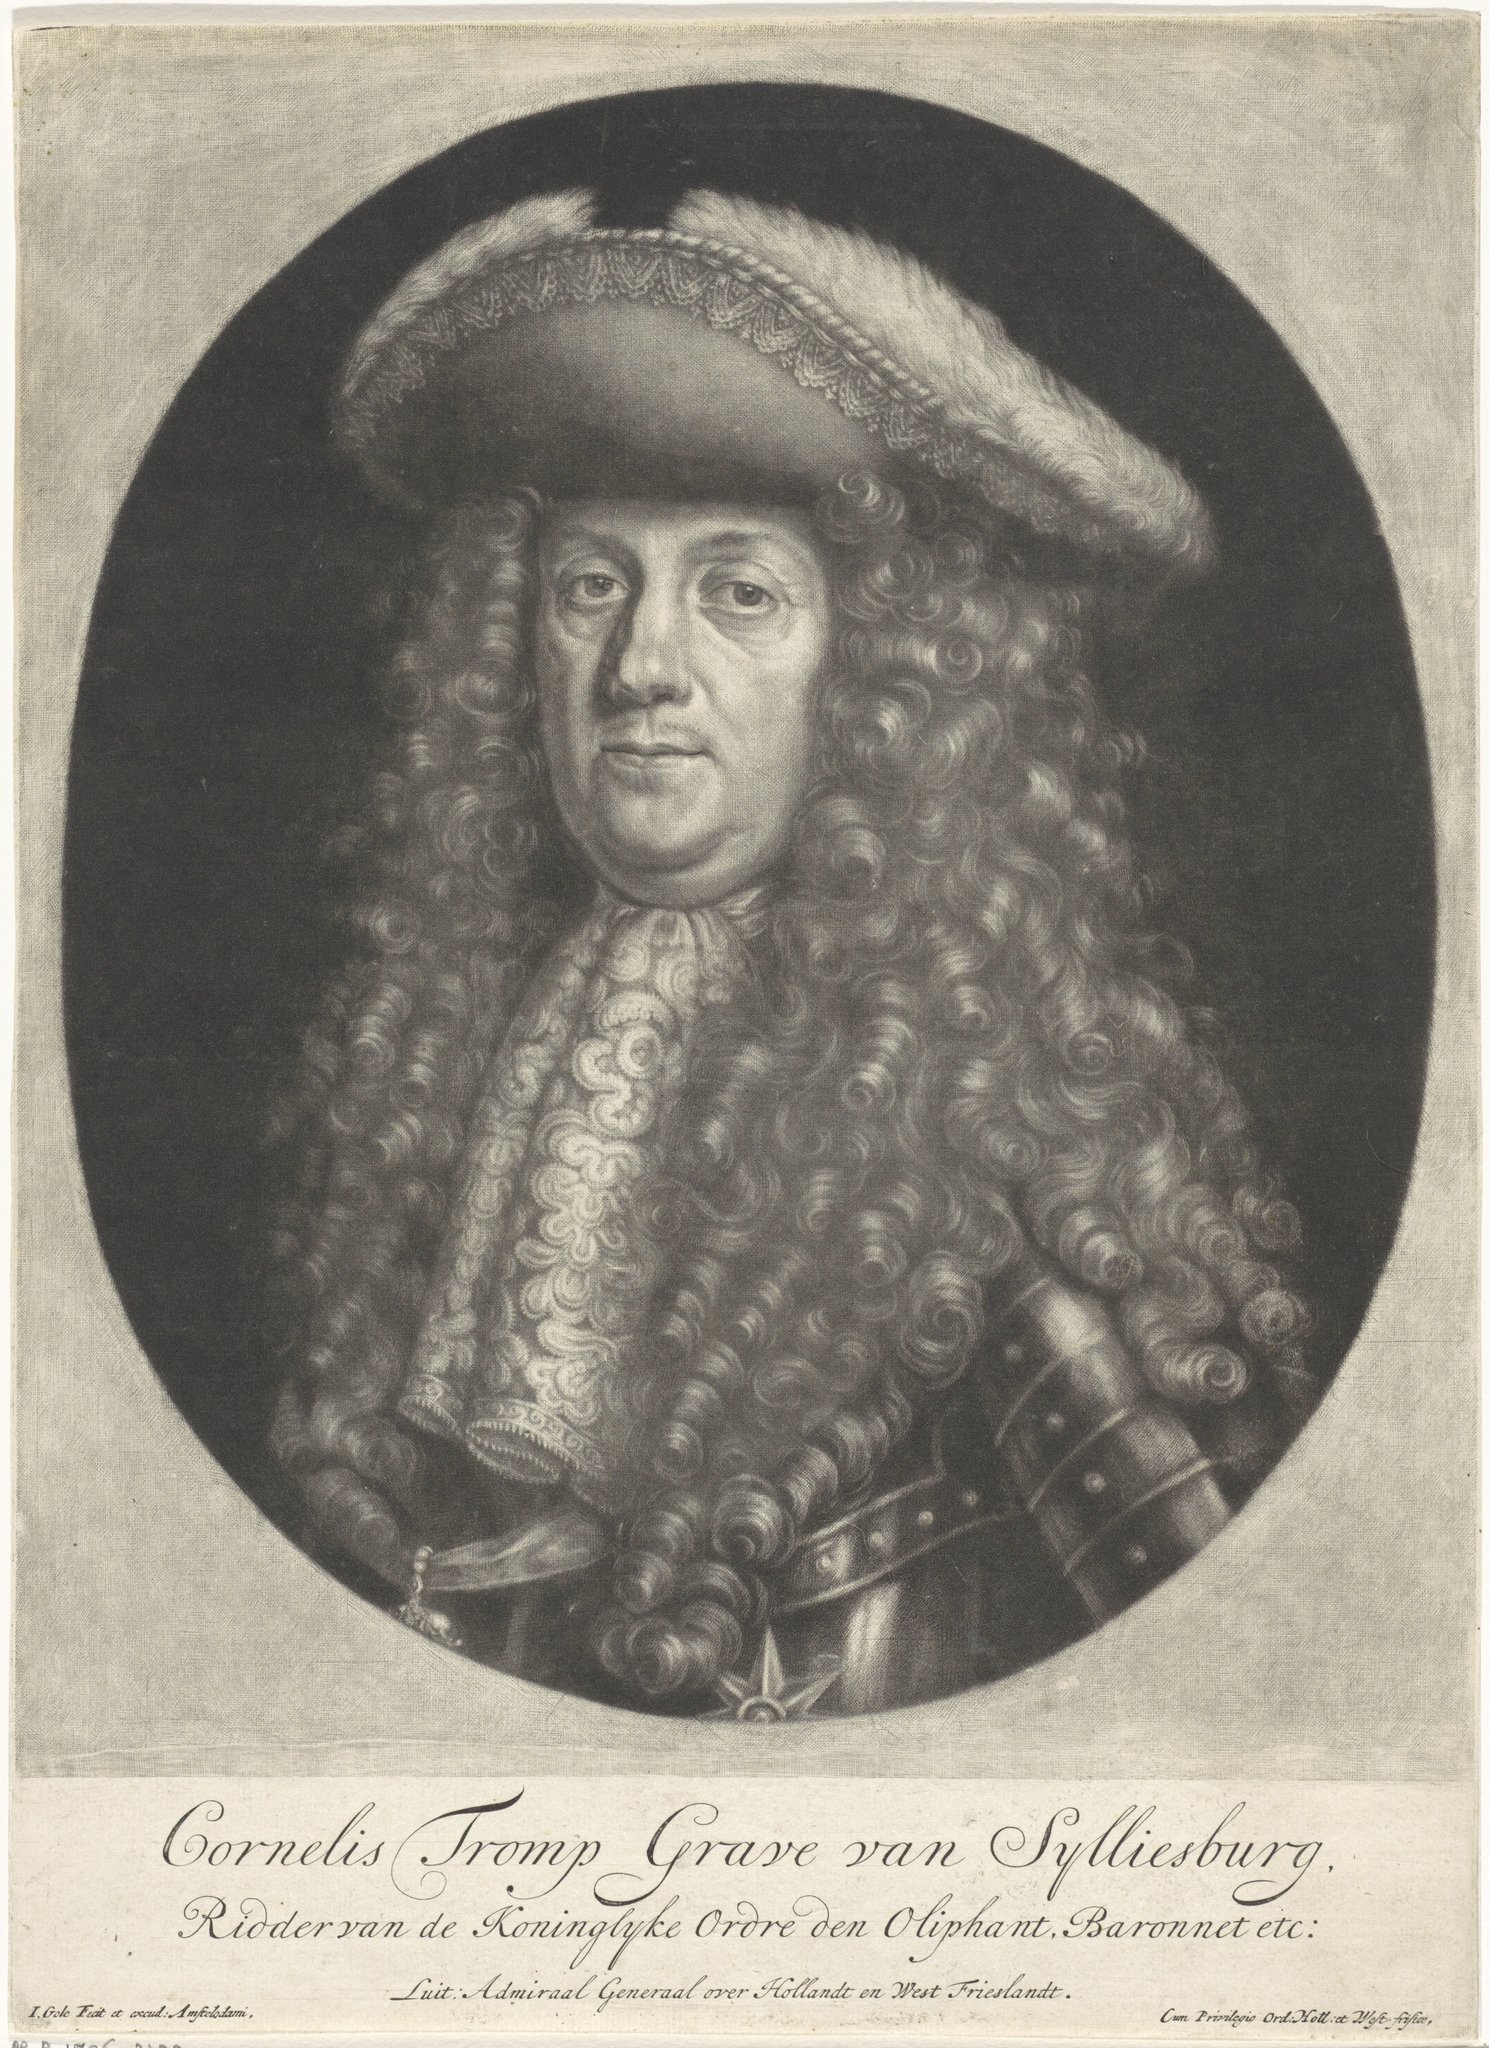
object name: print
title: Portret van Cornelis Tromp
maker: jacob gole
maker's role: print maker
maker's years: 1660-1724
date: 1670-1724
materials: paper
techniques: engraving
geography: amsterdam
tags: rotterdam, amsterdam, cornelis tromp, knighthood order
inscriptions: collector's mark: Lugt 2228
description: Admiraal Cornelis Tromp, gekleed in een harnas. Hij draagt het teken van de Orde van de Olifant. In de marge zijn naam en titels.